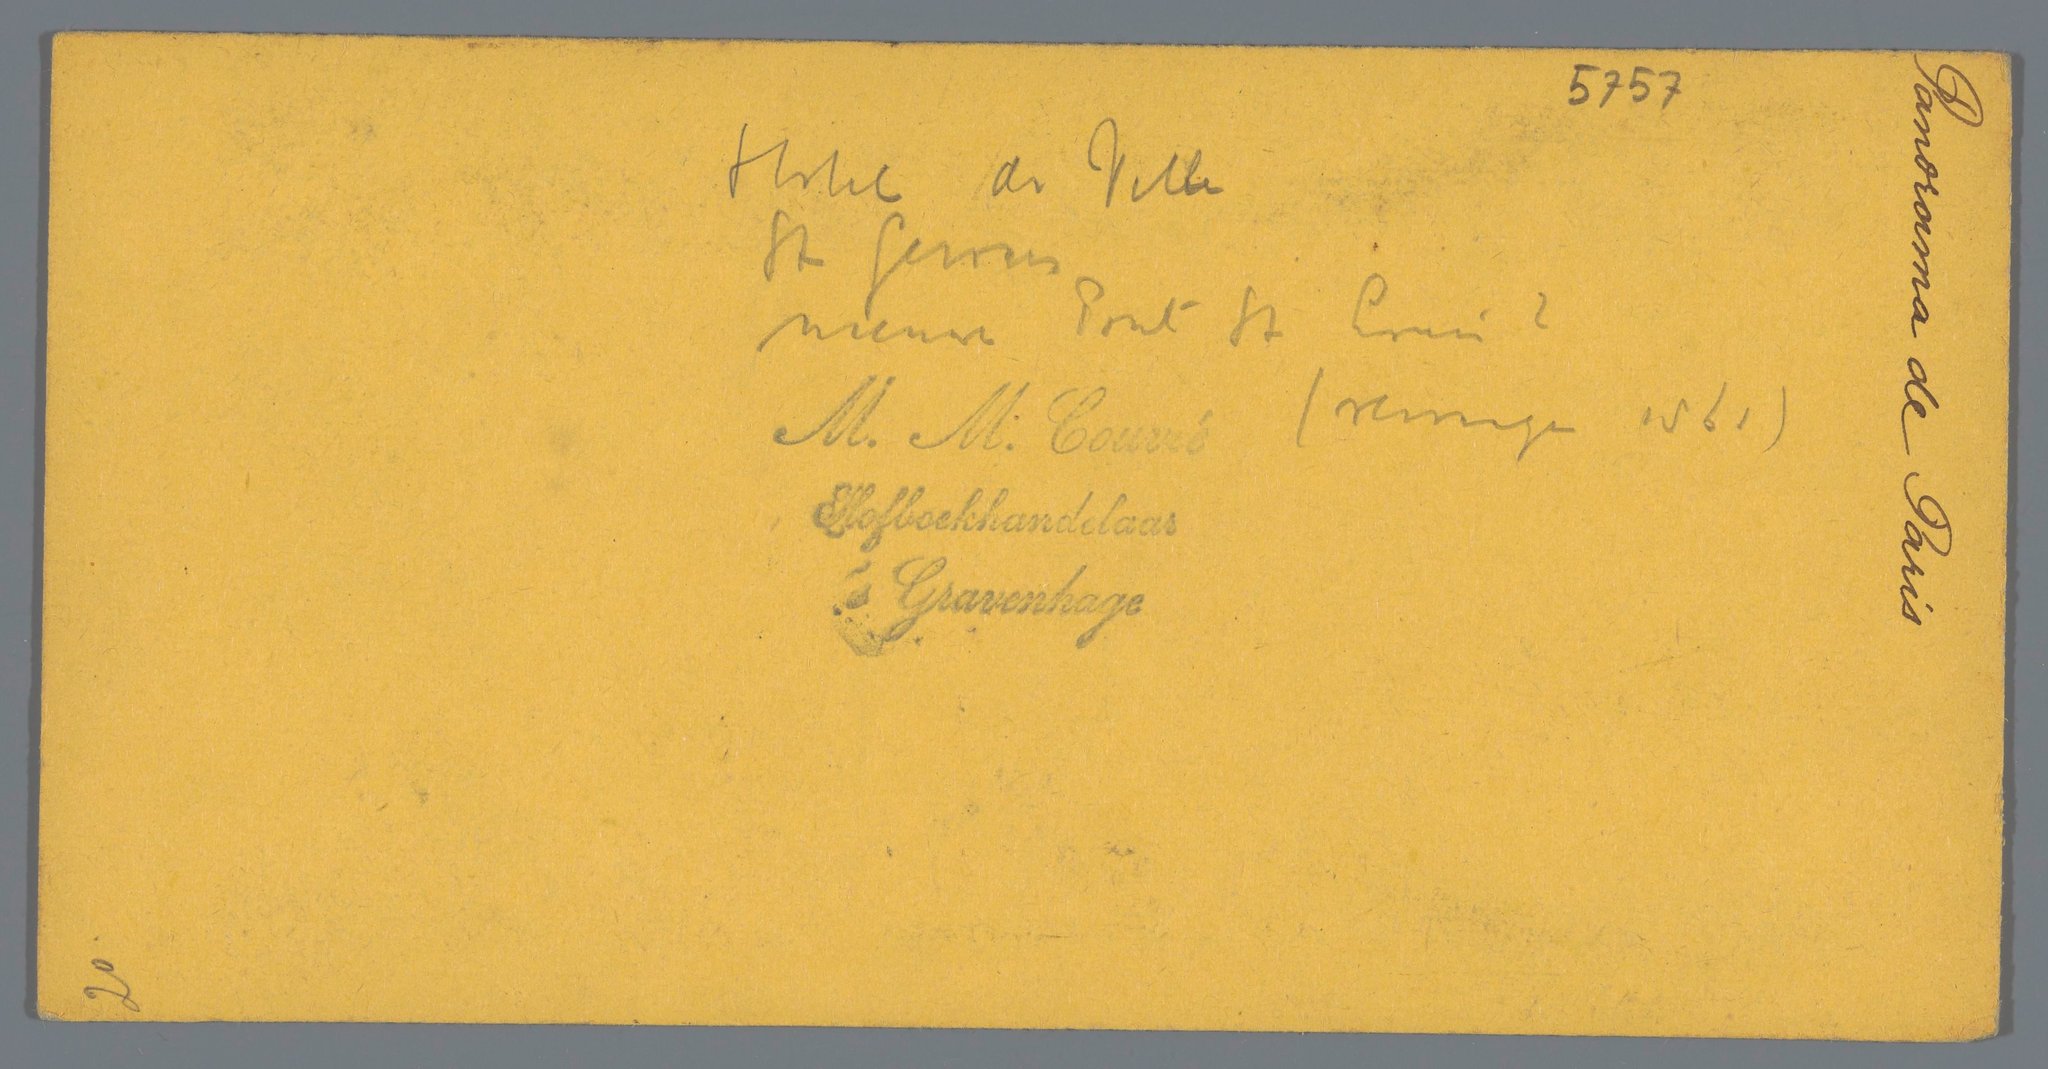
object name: stereograph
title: Gezicht op Parijs met het stadhuis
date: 1850-1880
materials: cardboard, photographic support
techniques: albumen print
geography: paris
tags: city-view, and landscape with man-made constructions, townhall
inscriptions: inscription: ‘Panorama de Paris Hotel de Ville st [...]’